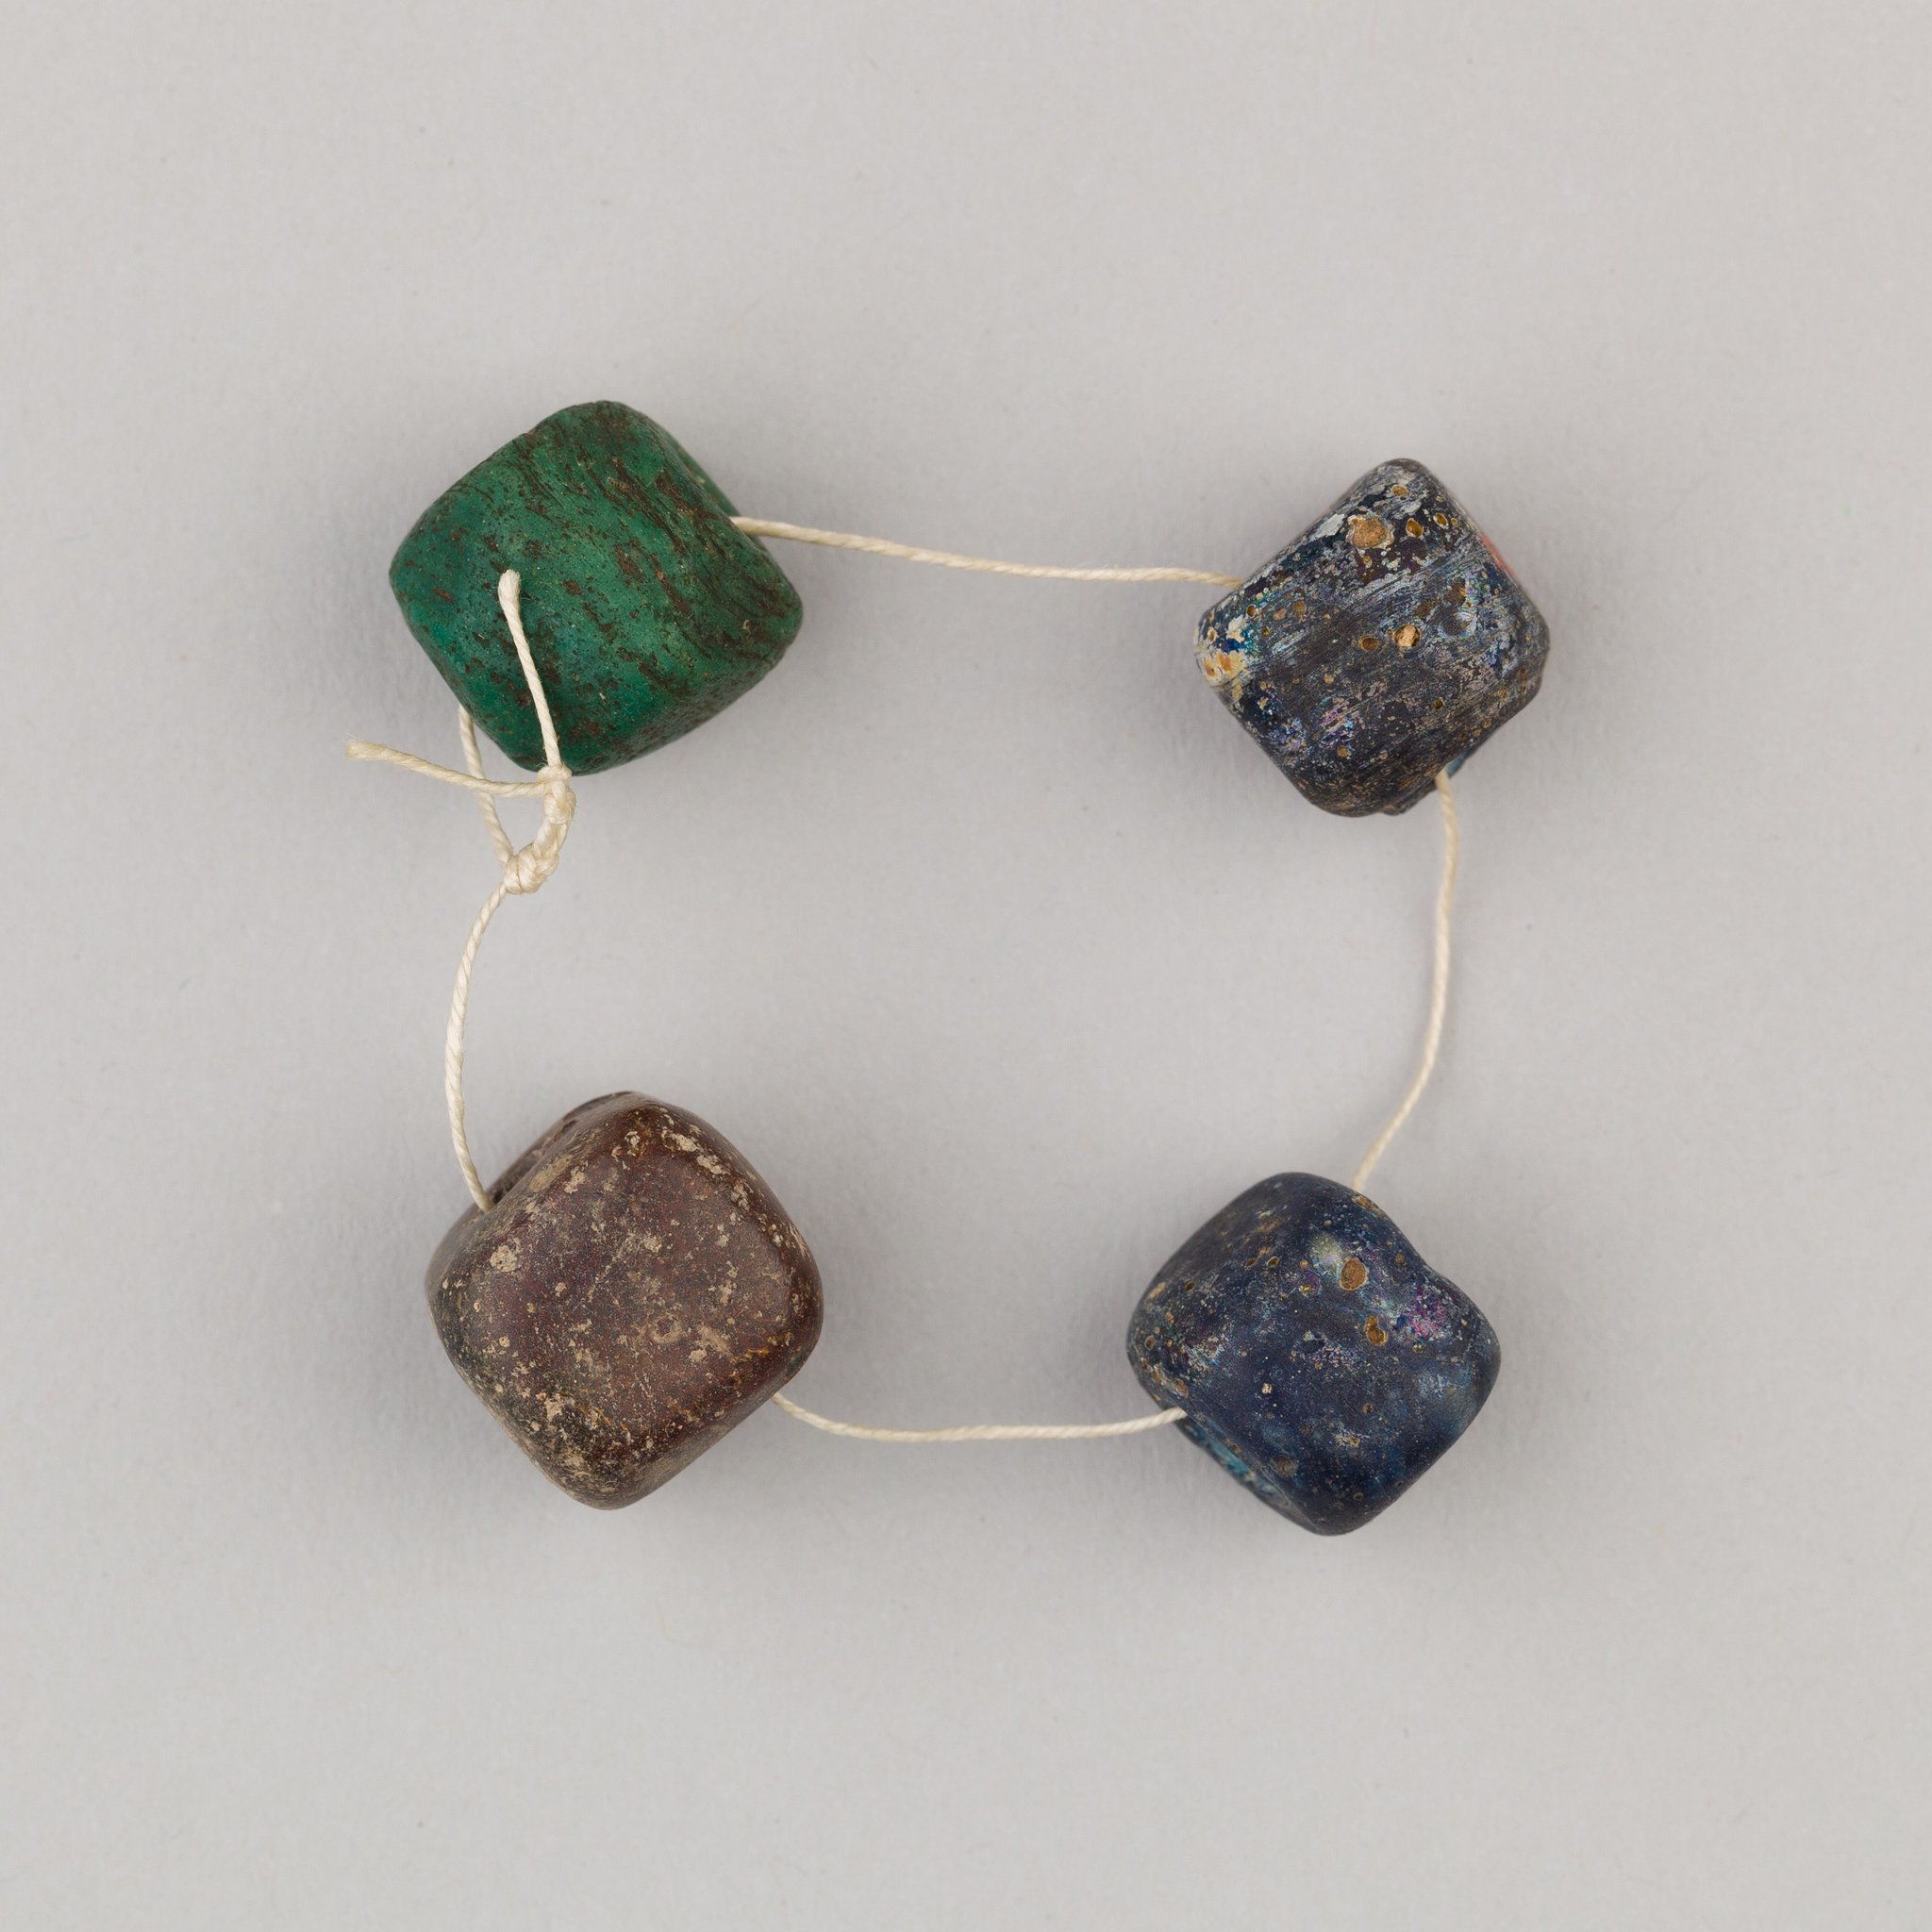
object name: bead, string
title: String of 4 beads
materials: glass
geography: egypt